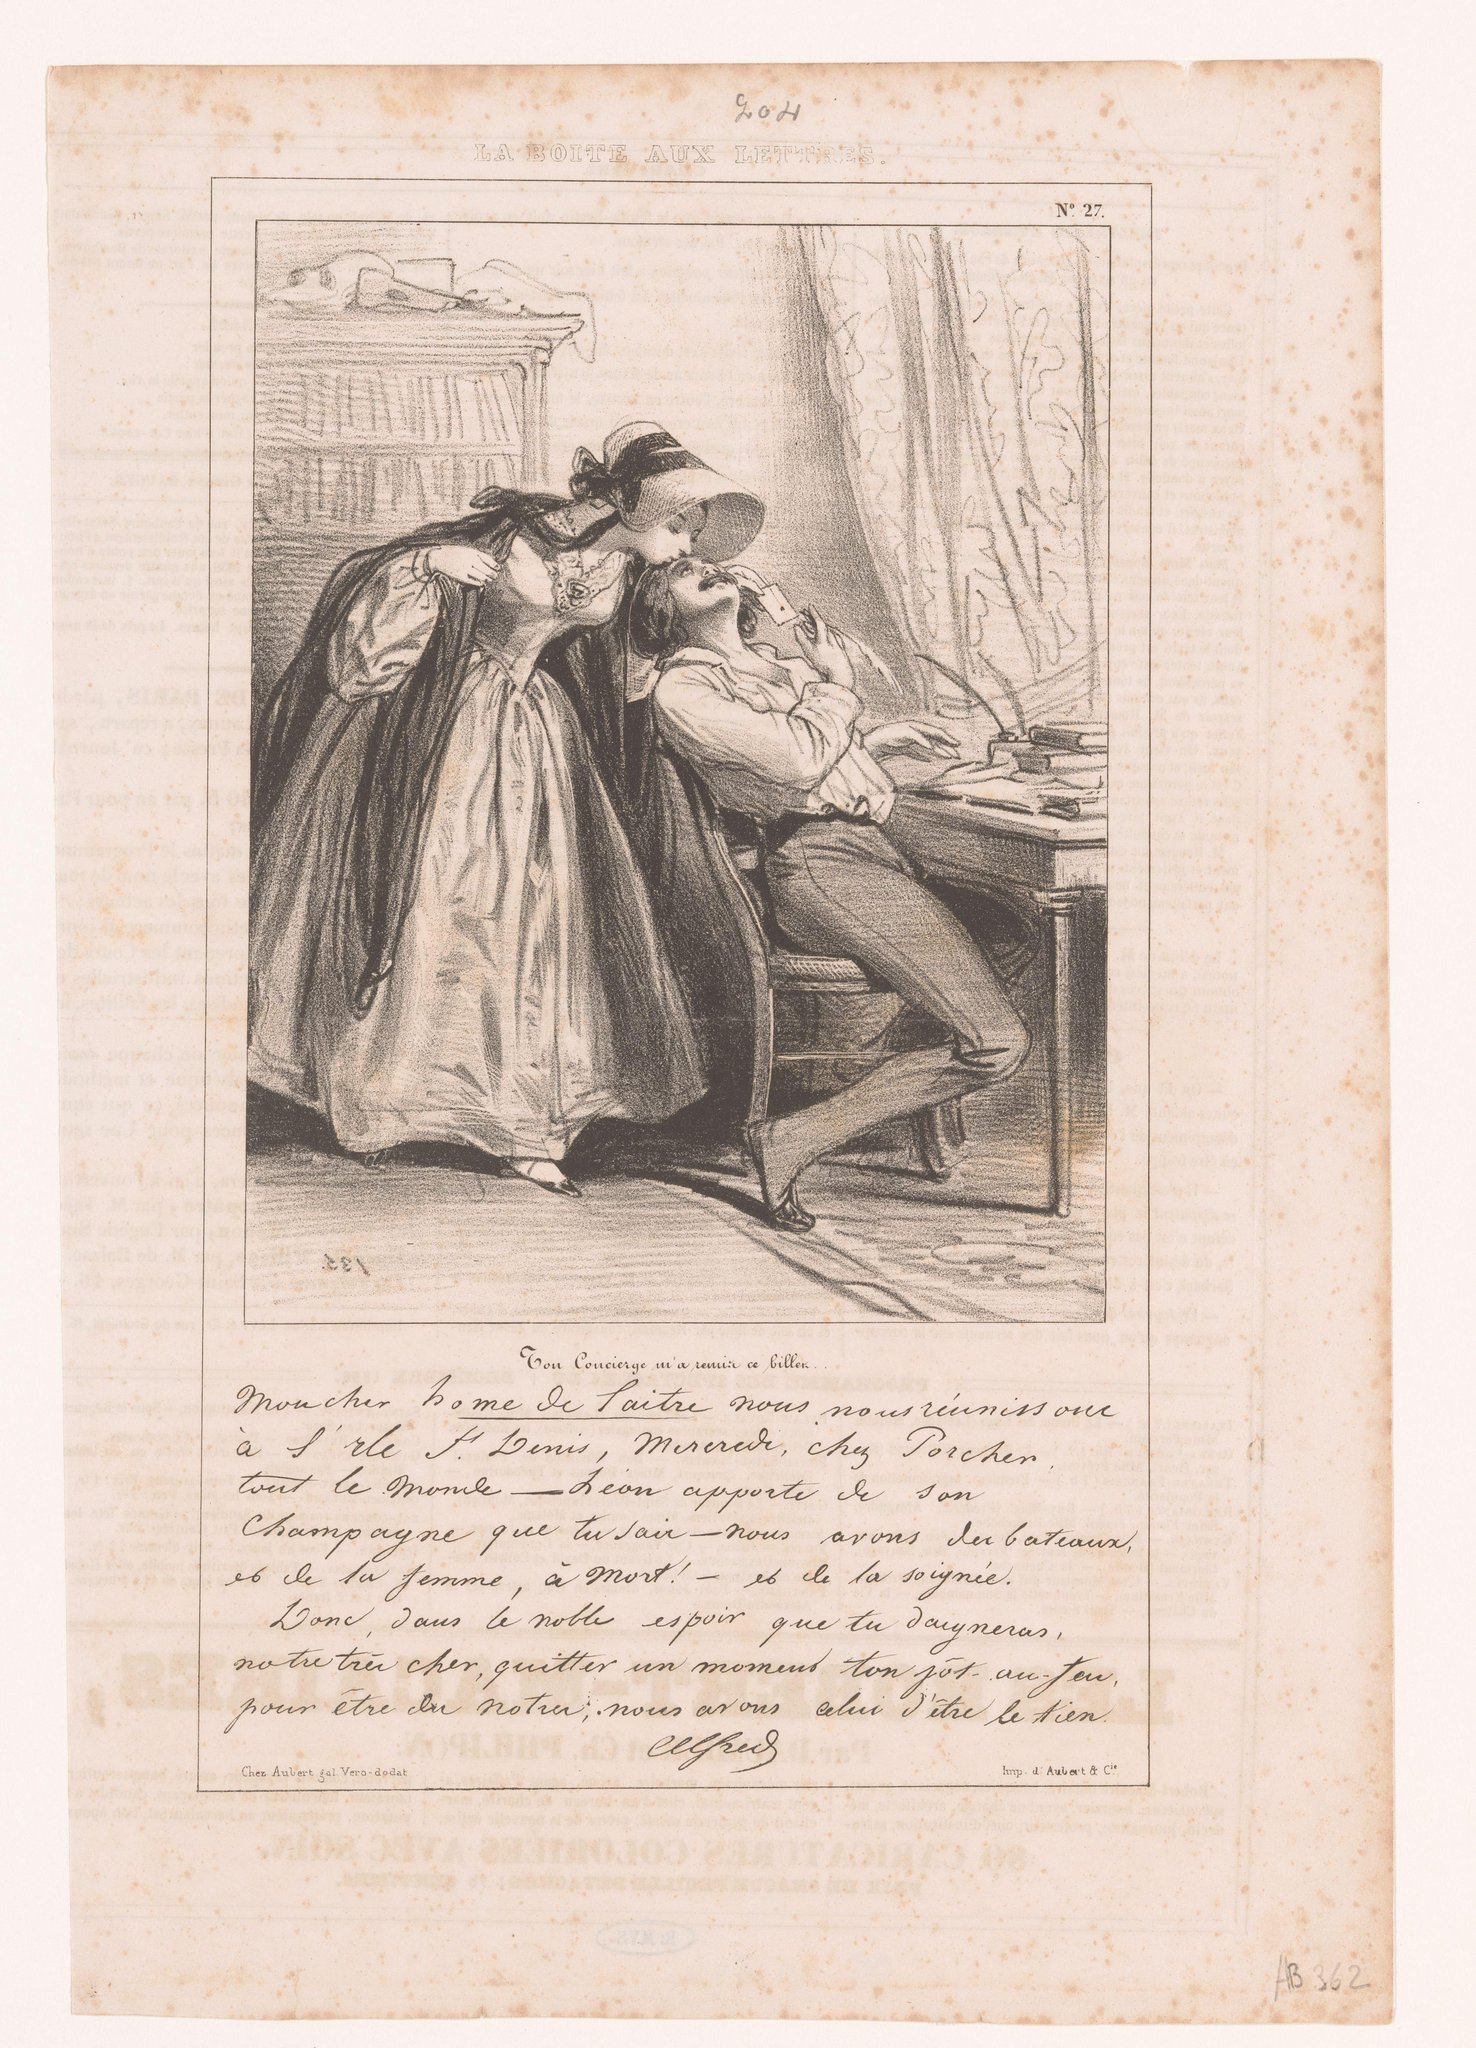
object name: print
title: Brieven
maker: paul gavarni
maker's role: draughtsman, print maker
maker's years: 1804-1866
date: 1838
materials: paper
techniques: lithograph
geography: paris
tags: marriage, married couple, 'matrimonium', letter, envelope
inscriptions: collector's mark: Lugt 2228a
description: De brief is van de huismeester en is bedoeld voor de vrouw.